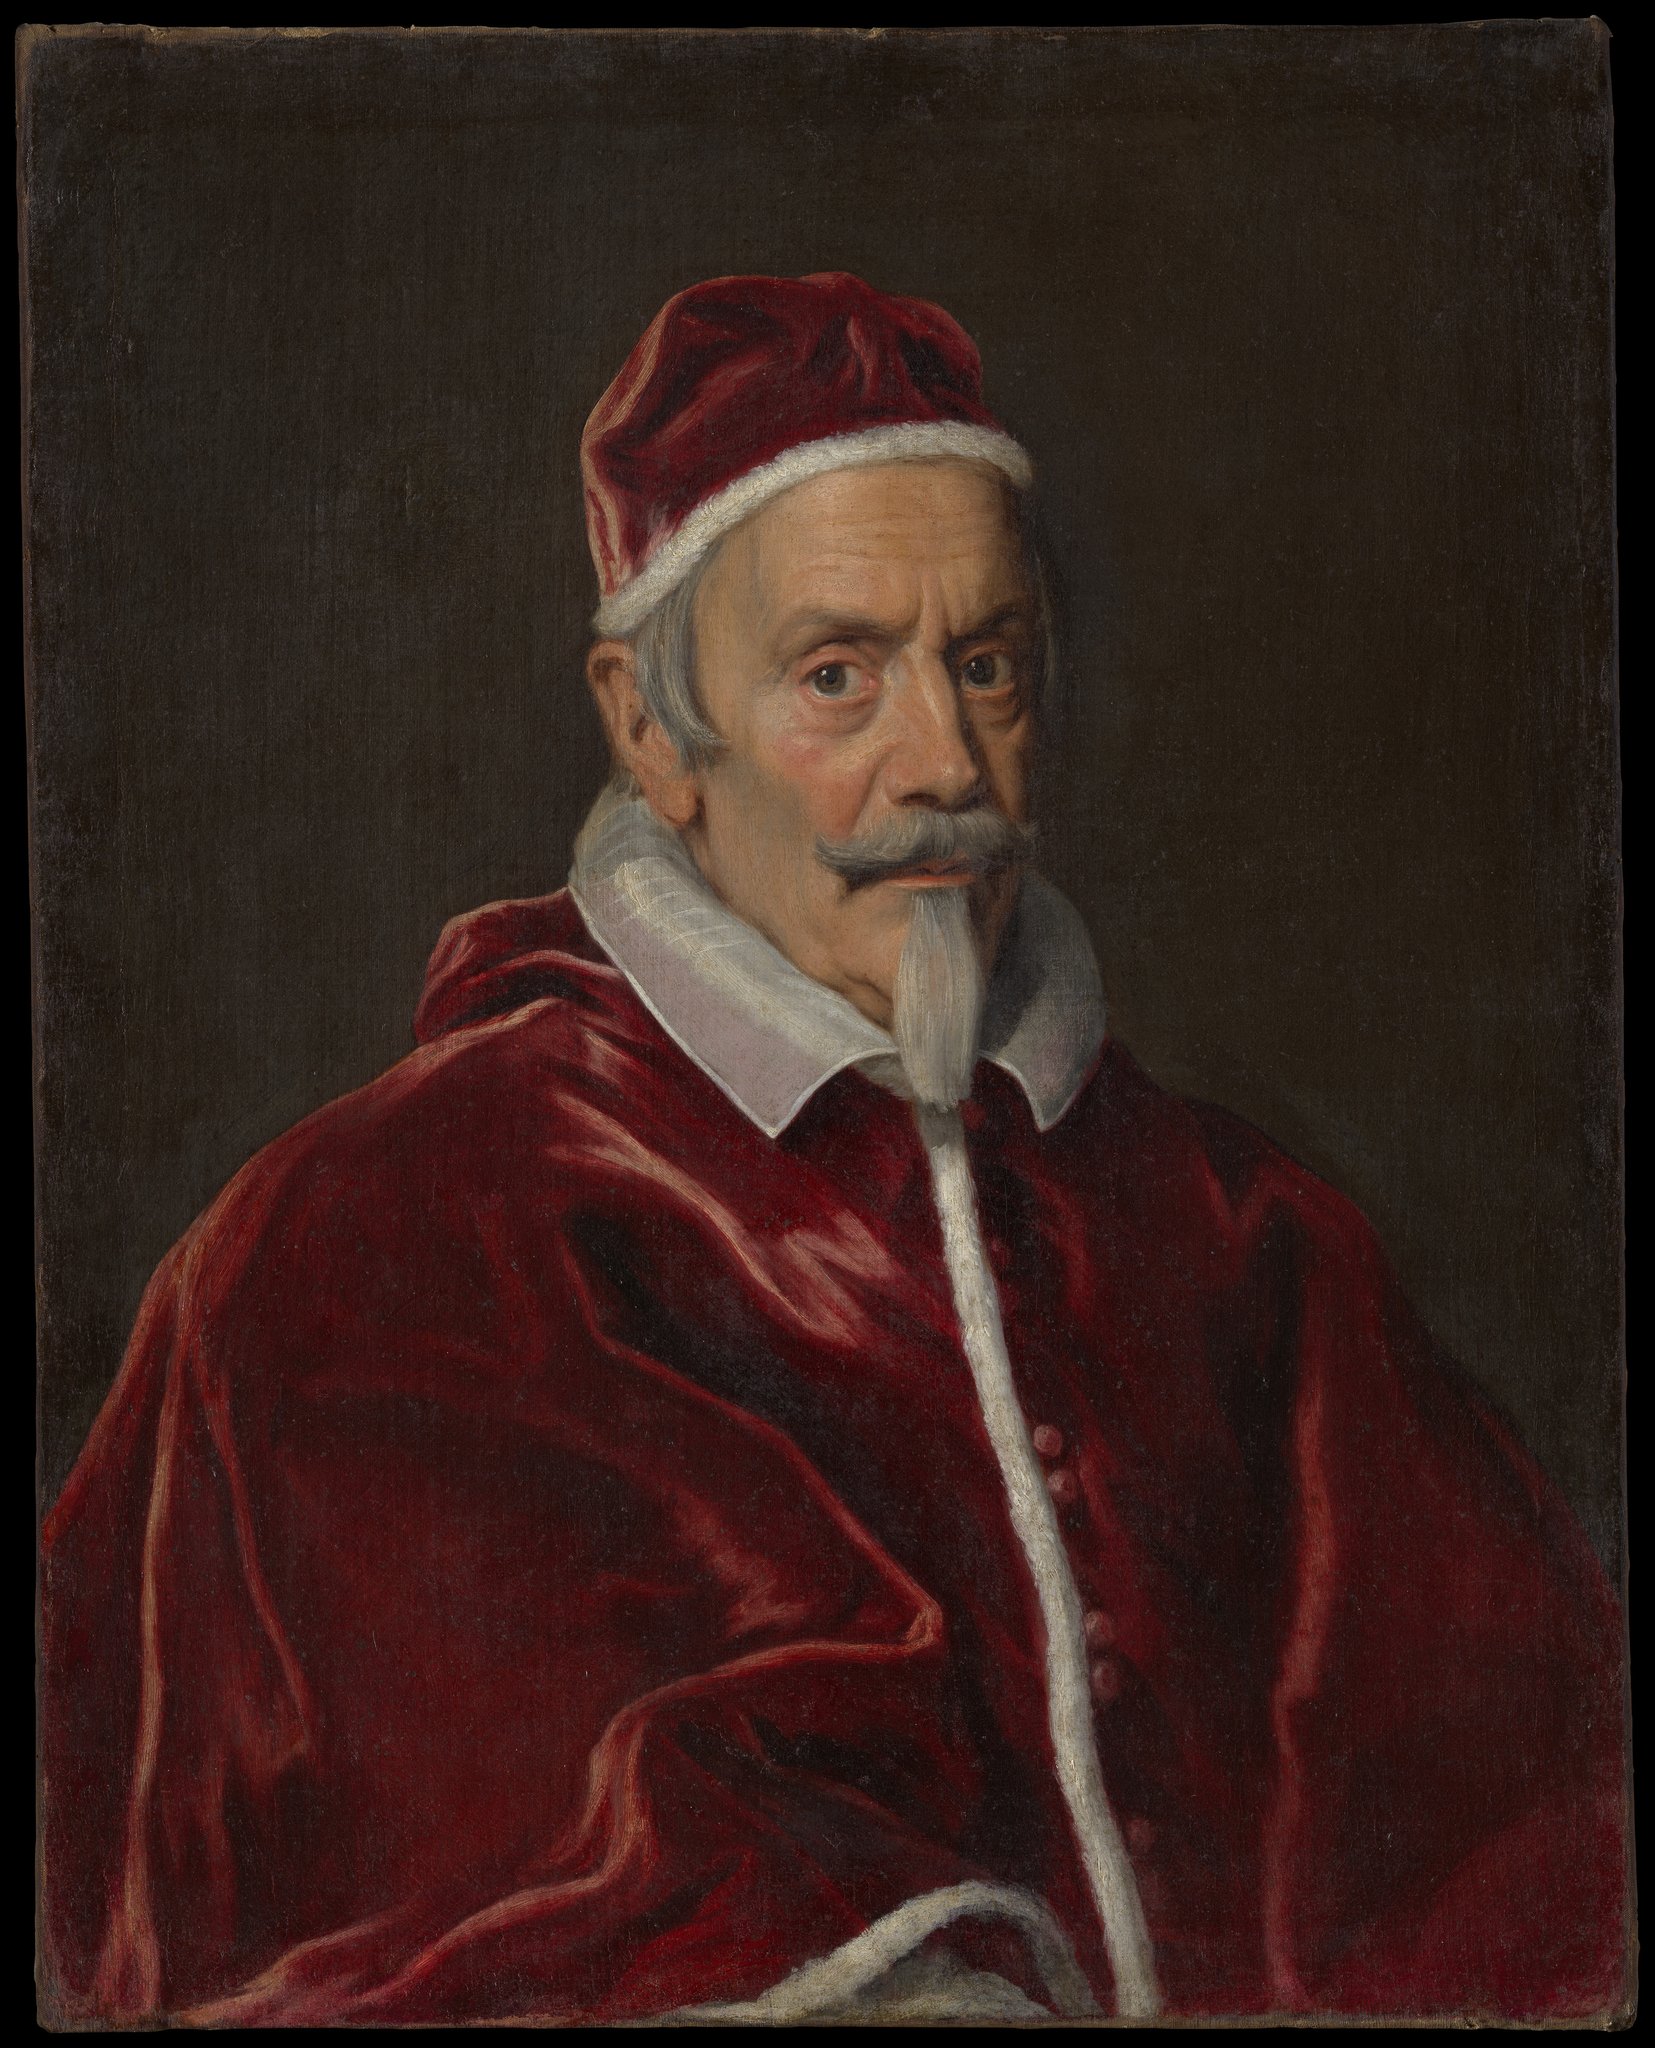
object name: painting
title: Pope Clement X (1590–1676)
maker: giovanni battista gaulli (il baciccio)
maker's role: artist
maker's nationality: italian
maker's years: 1639-1709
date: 1670-1671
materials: canvas, oil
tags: men,portraits,popes